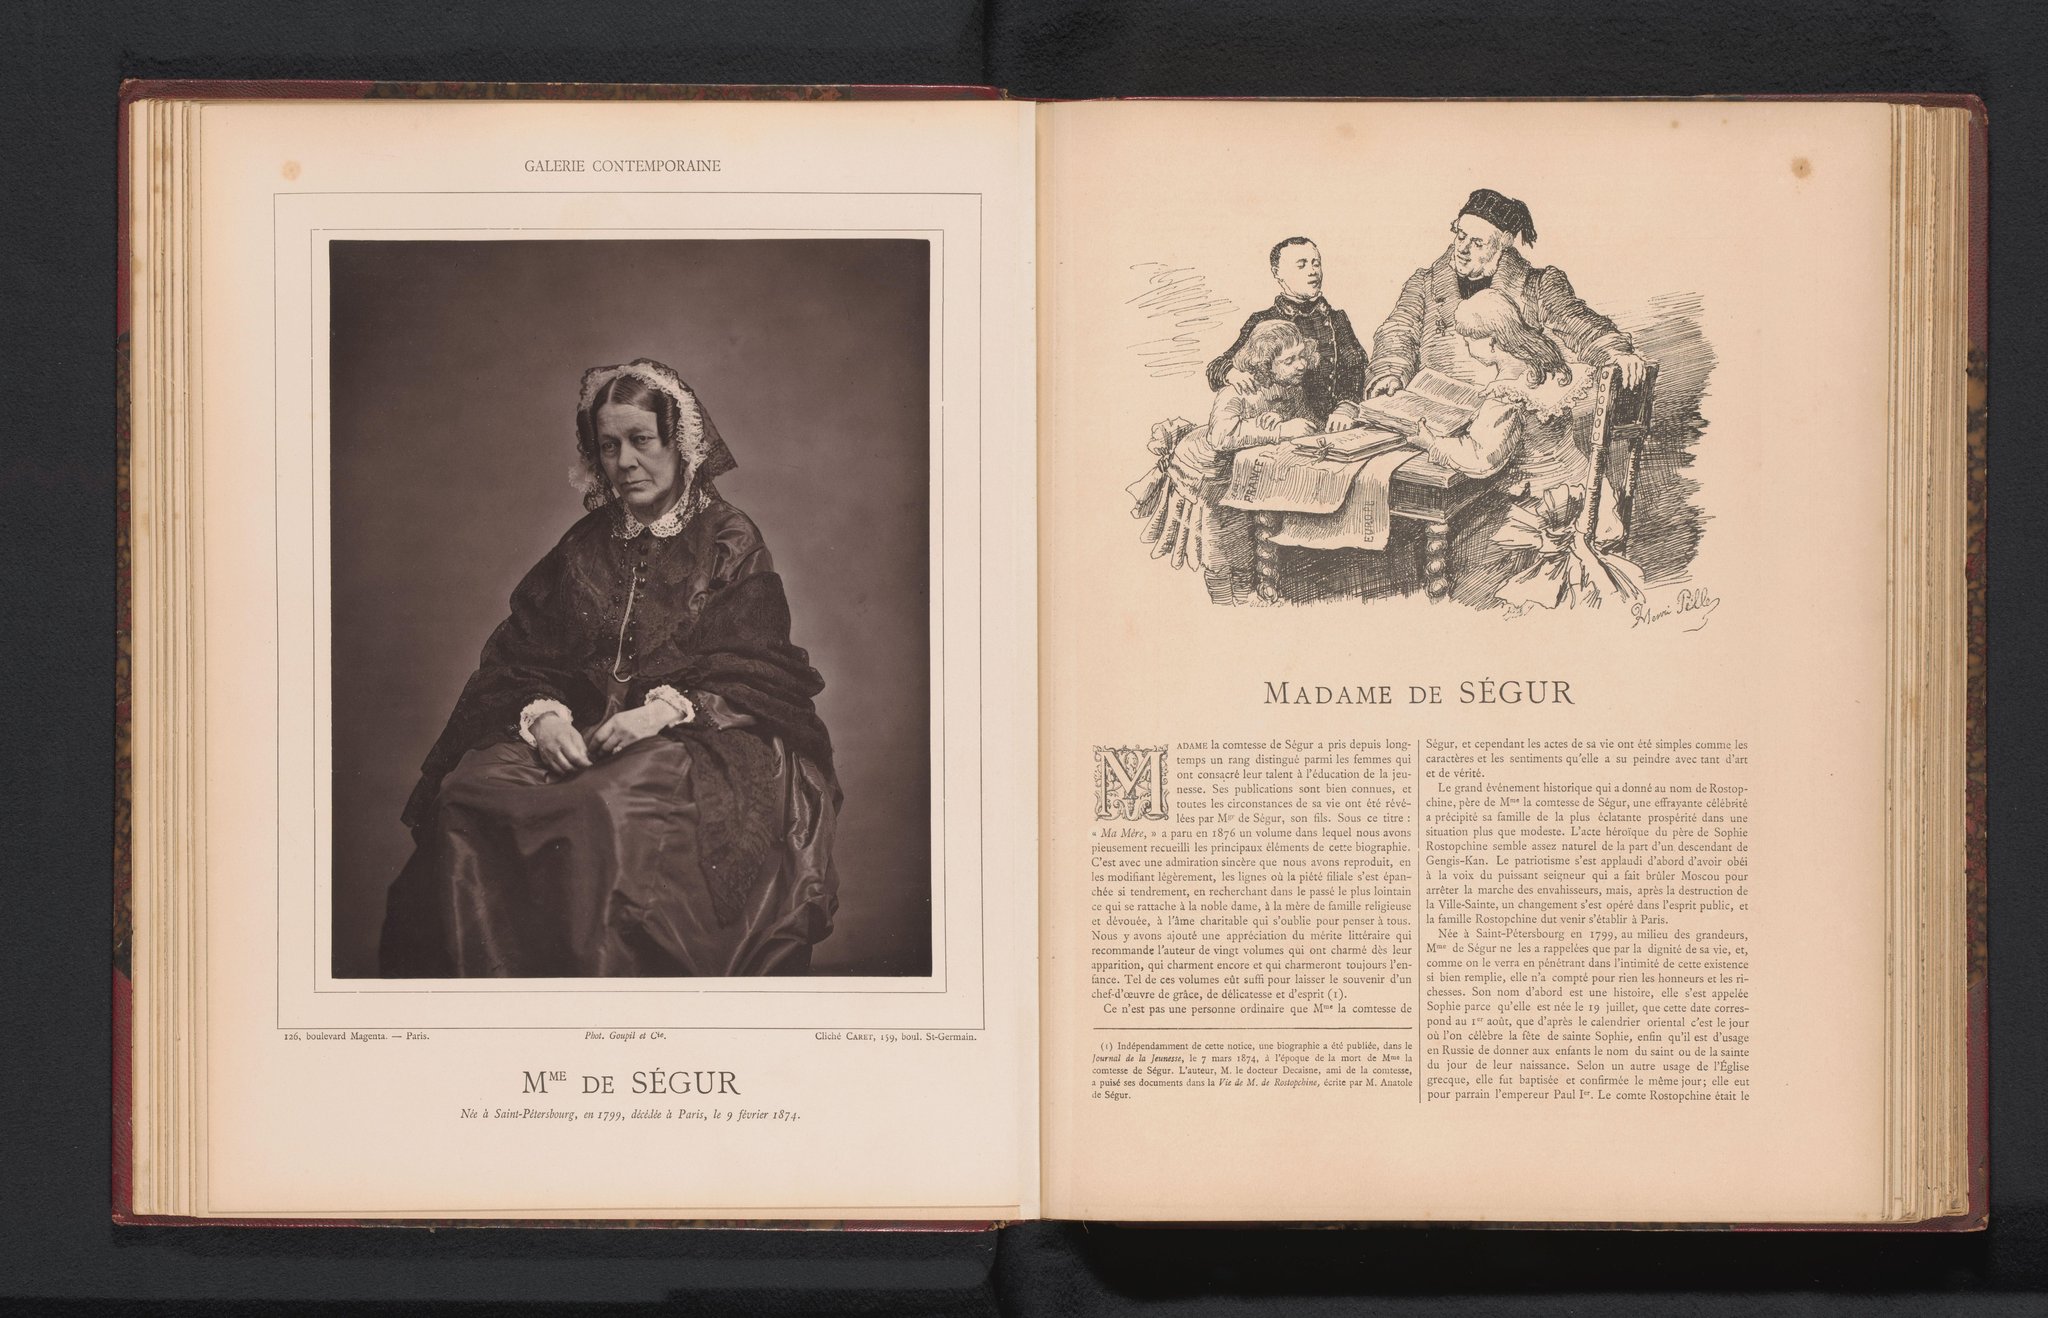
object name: page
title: Mme de Ségur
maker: caret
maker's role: fotograaf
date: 1873-1878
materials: paper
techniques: woodburytype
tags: paris, adult woman, historical persons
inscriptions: inscription: ‘Galerie Contemporaine/ 126, boulevard Magenta. - Paris./ Né à Saint-Pétersbourg, en 1799, décédée à Paris, le 9 février 1874.’